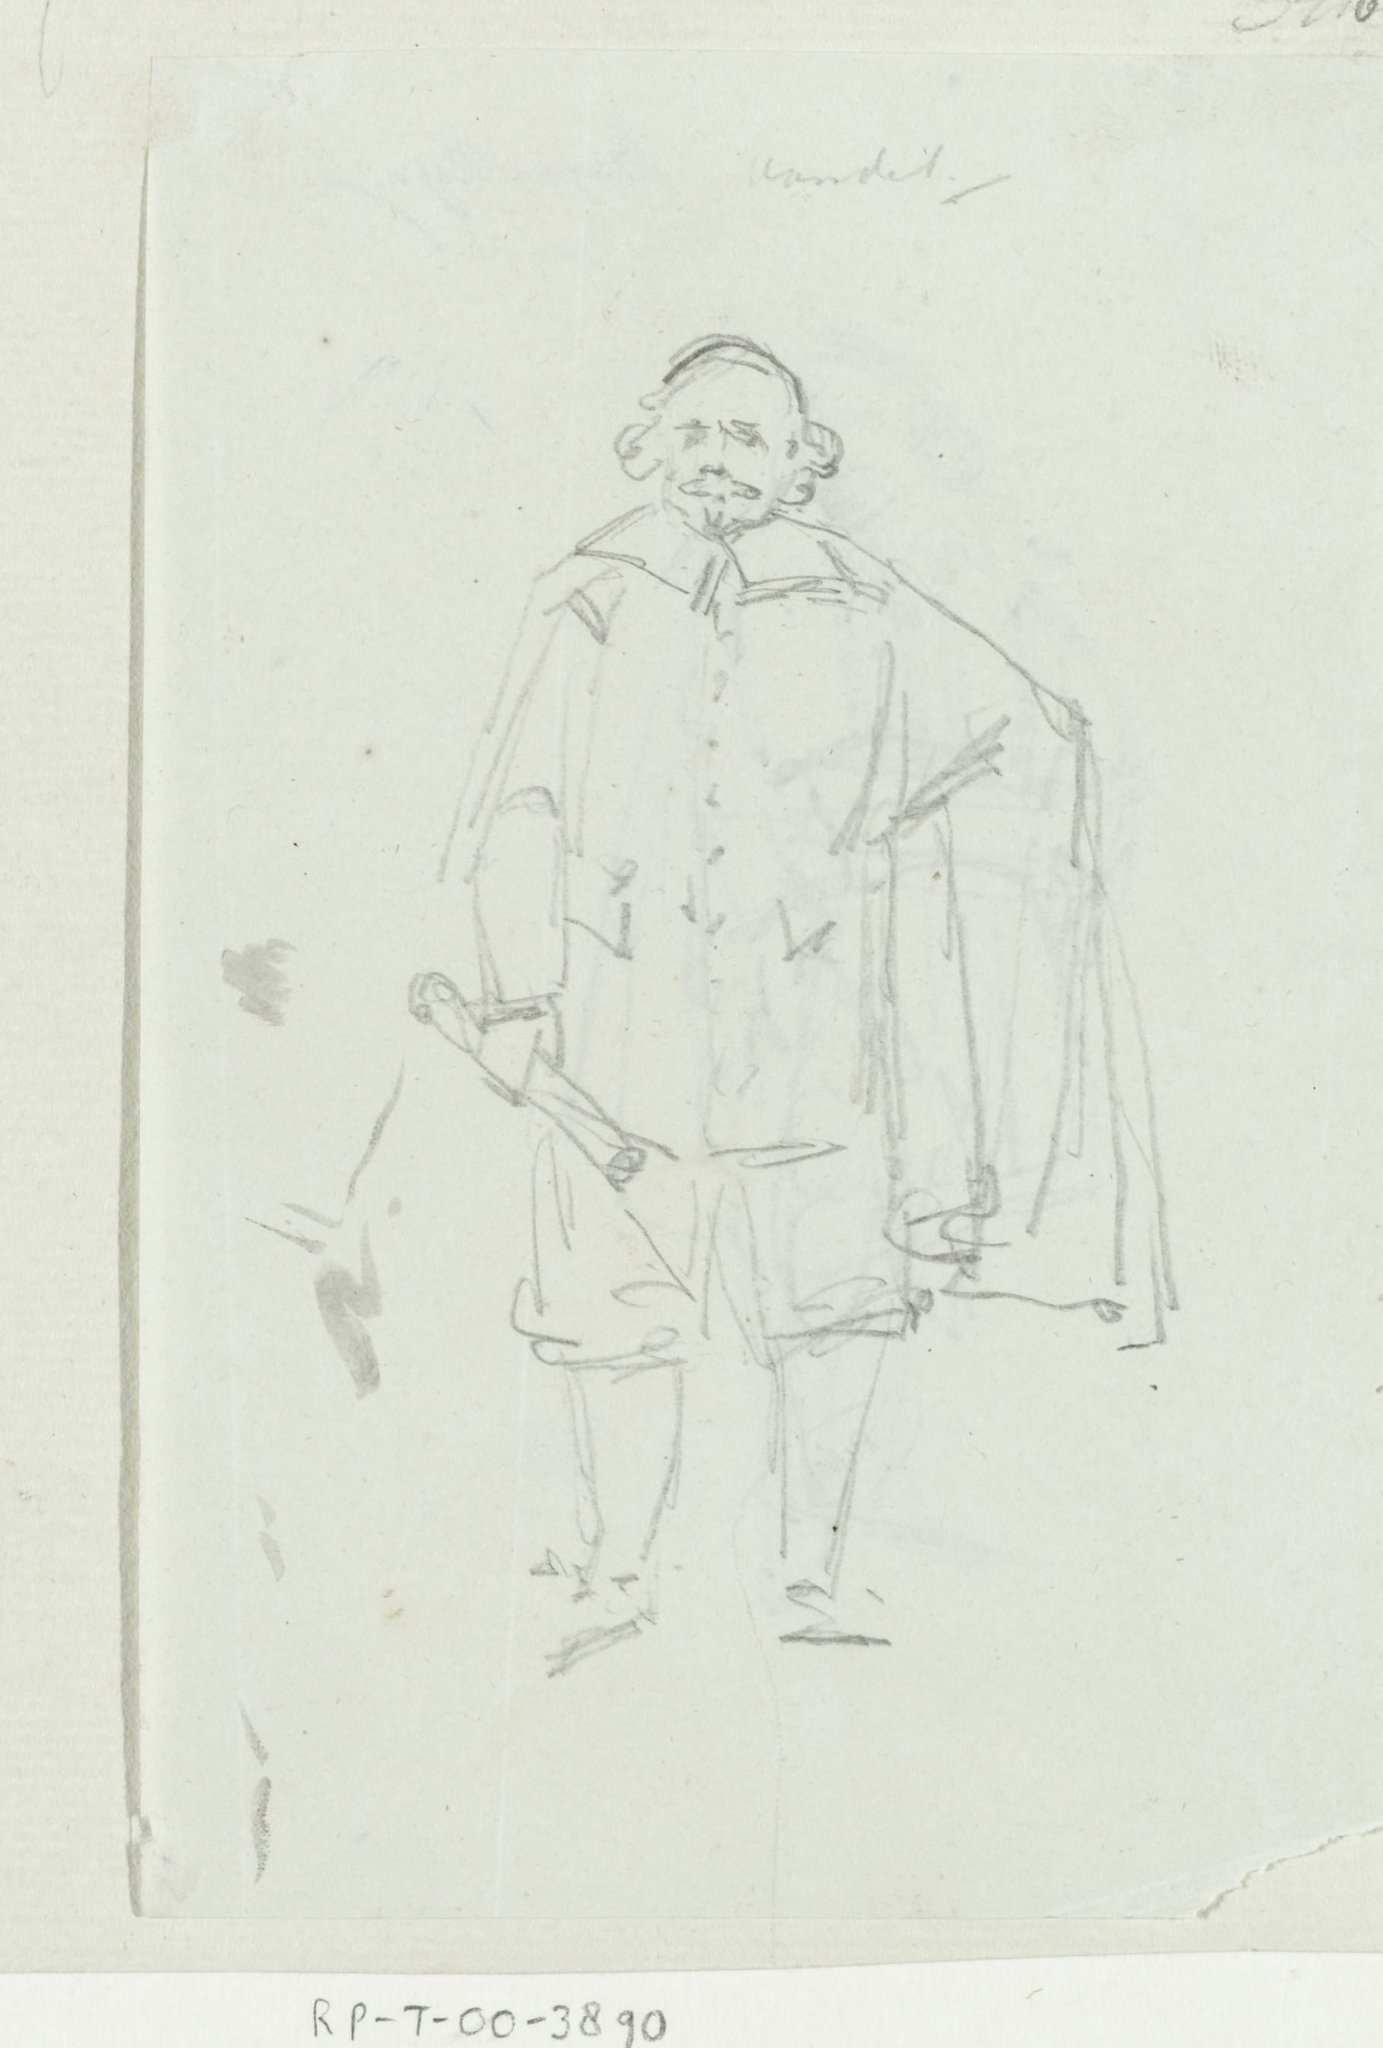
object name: drawing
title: Vondel in de toneelvoorstelling op het tweede eeuwfeest van het Athenaeum Illustre te Amsterdam, 1832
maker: Anonymous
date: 1832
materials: paper, pencil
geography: amsterdam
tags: cologne, joost van den vondel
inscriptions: collector's mark: Lugt 2228, inscription: ‘Vondel’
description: De dichter Joost van den Vondel, personage tijdens de toneelavond ter gelegenheid van het tweede eeuwfeest (1632-1832) van het Athenaeum Illustre te Amsterdam, gevierd in de Stadsschouwburg te Amsterdam op 10 januari 1832. Op de achterzijde is een andere figuur getekend.